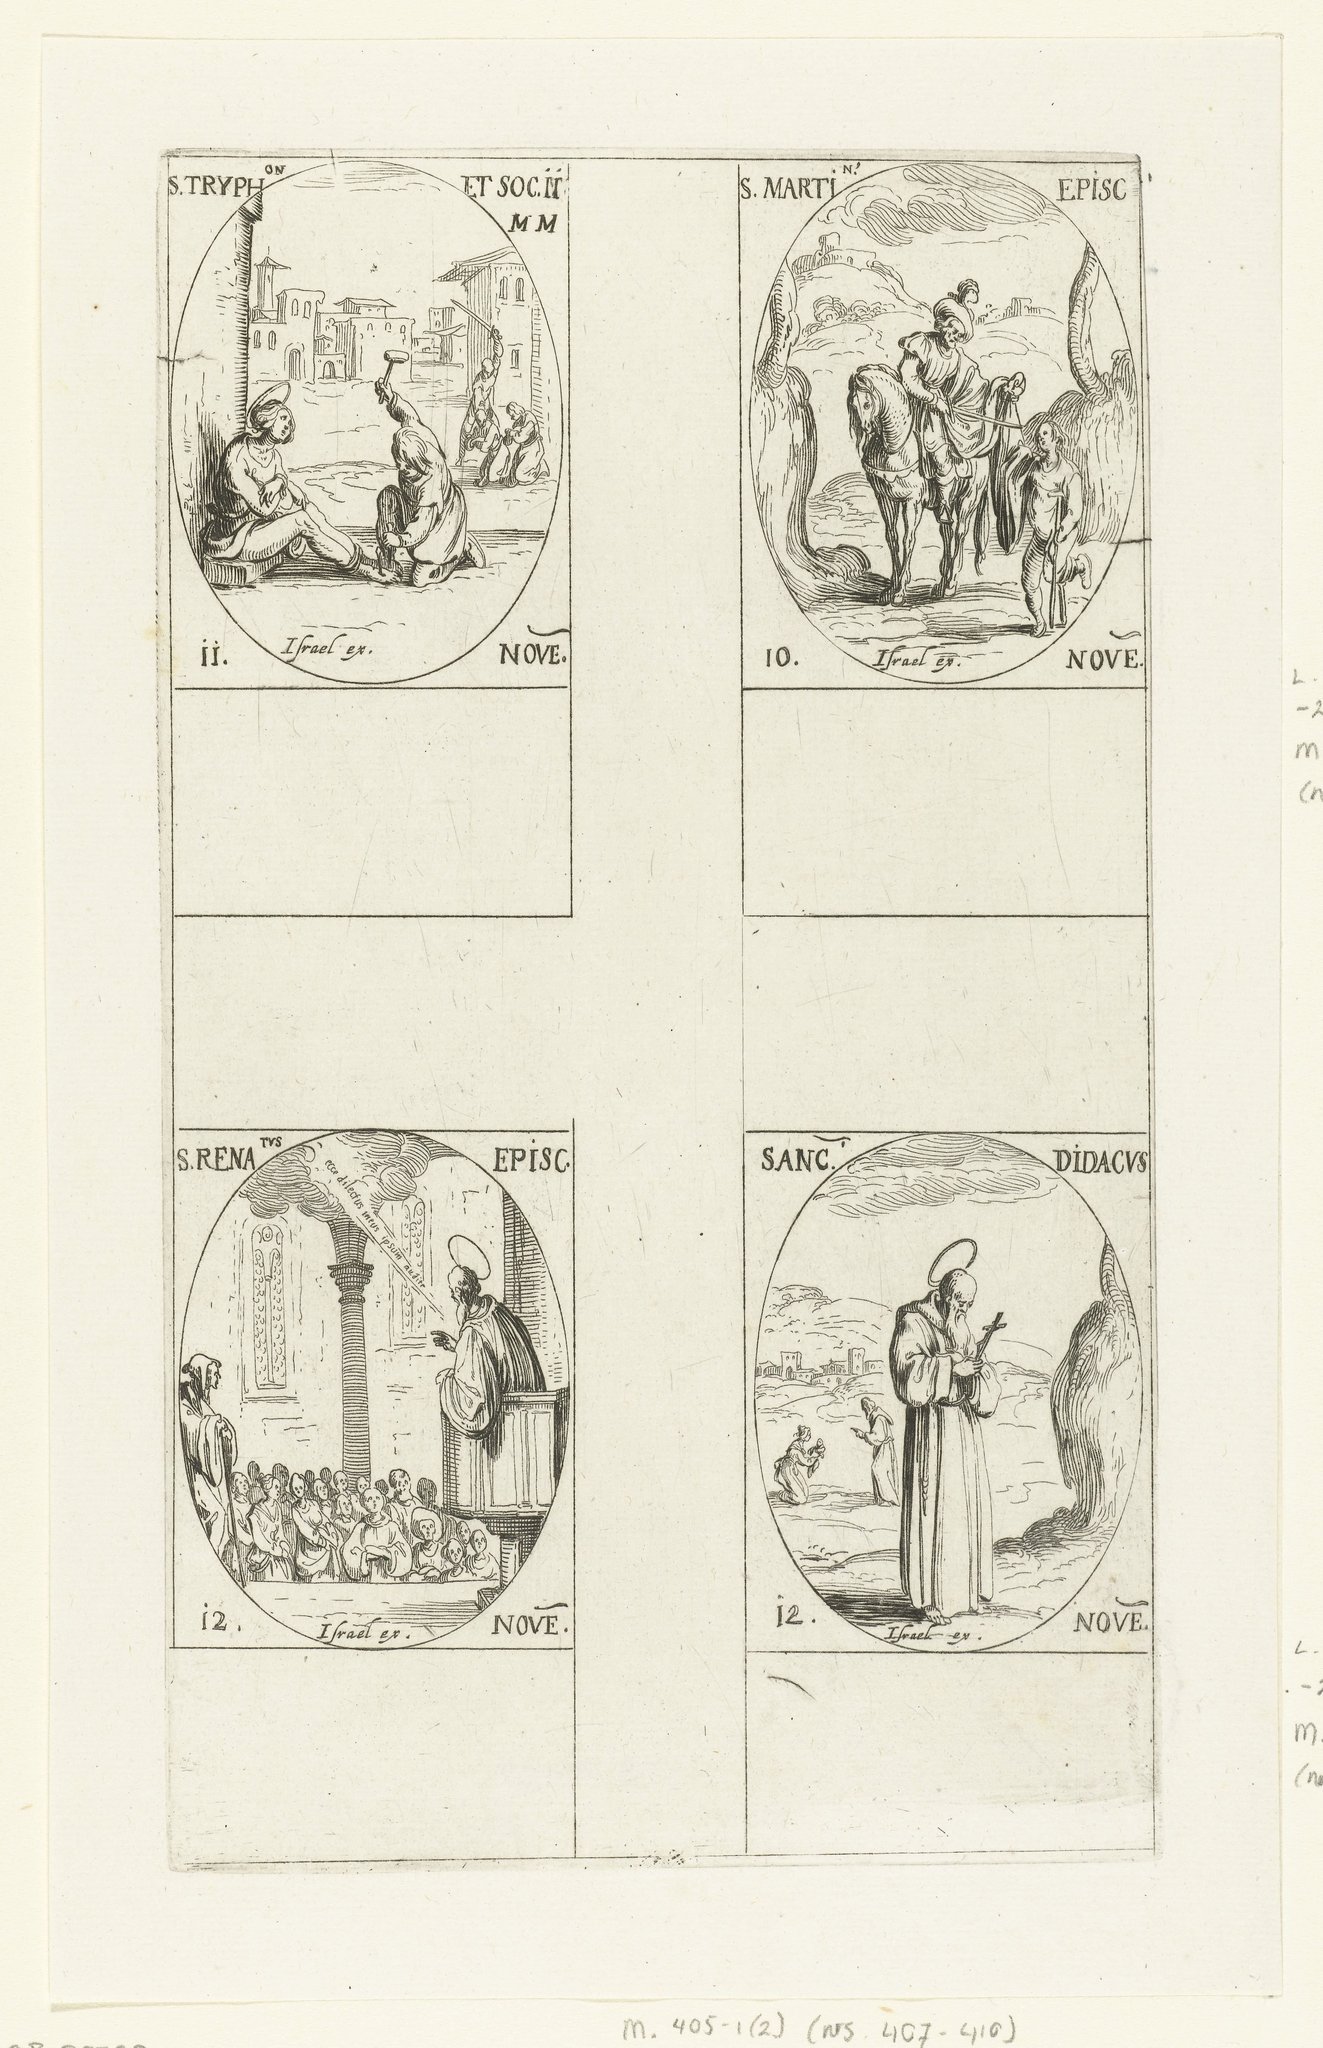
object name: print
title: Heilige Martinus van Tours, Heilige Tryphon van Cattaro en gezellen, Heilige Renatus van Angers, Heilige Didacus van Alcalá (10-12 november)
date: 1632-1636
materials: paper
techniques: etching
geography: nancy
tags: st. martin divides his cloak (i.e. the charity of st. martin): he is usually shown on horseback, cutting his cloak with his sword, or putting part of the cloak round the shoulders of a beggar who kneels beside him, the franciscan friar di(a)dacus of alcala; possible attributes: cooking-pot, cross, flowers, keys, male saints (with name)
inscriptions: collector's mark: Lugt 240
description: Blad met vier ovale voorstellingen, elk met opschrift en datum in het Latijn: rechtsboven de Heilige Martinus van Tours te paard die de helft van zijn mantel aan een man op krukken afstaat (bij deze voorstelling staat 10 november, moet 11 november zijn), linksboven de Heilige Tryphon van Cattaro bij wie spijkers door zijn voeten worden geslagen (bij deze voorstelling staat 11 november, moet 10 november zijn), linksonder de Heilige Renatus van Angers die preekt voor een gemeente, rechtsonder de Heilige Didacus van Alcalá die peinzend kijkt naar een crucifix in zijn handen. Deze prent is onderdeel van een serie prenten met voorstellingen van de heiligen en de christelijke feestdagen van het jaar. Er zijn steeds vier scènes van één plaat op één blad gedrukt. Inclusief bijbehorend titelblad en frontispice gaat het in totaal om 124 platen (490 voorstellingen). De drie platen met de laatste 12 scènes (de veranderlijke christelijke feestdagen) zijn in de derde staat versneden tot 12 kleine plaatjes, en met een apart titelblad uitgegeven.